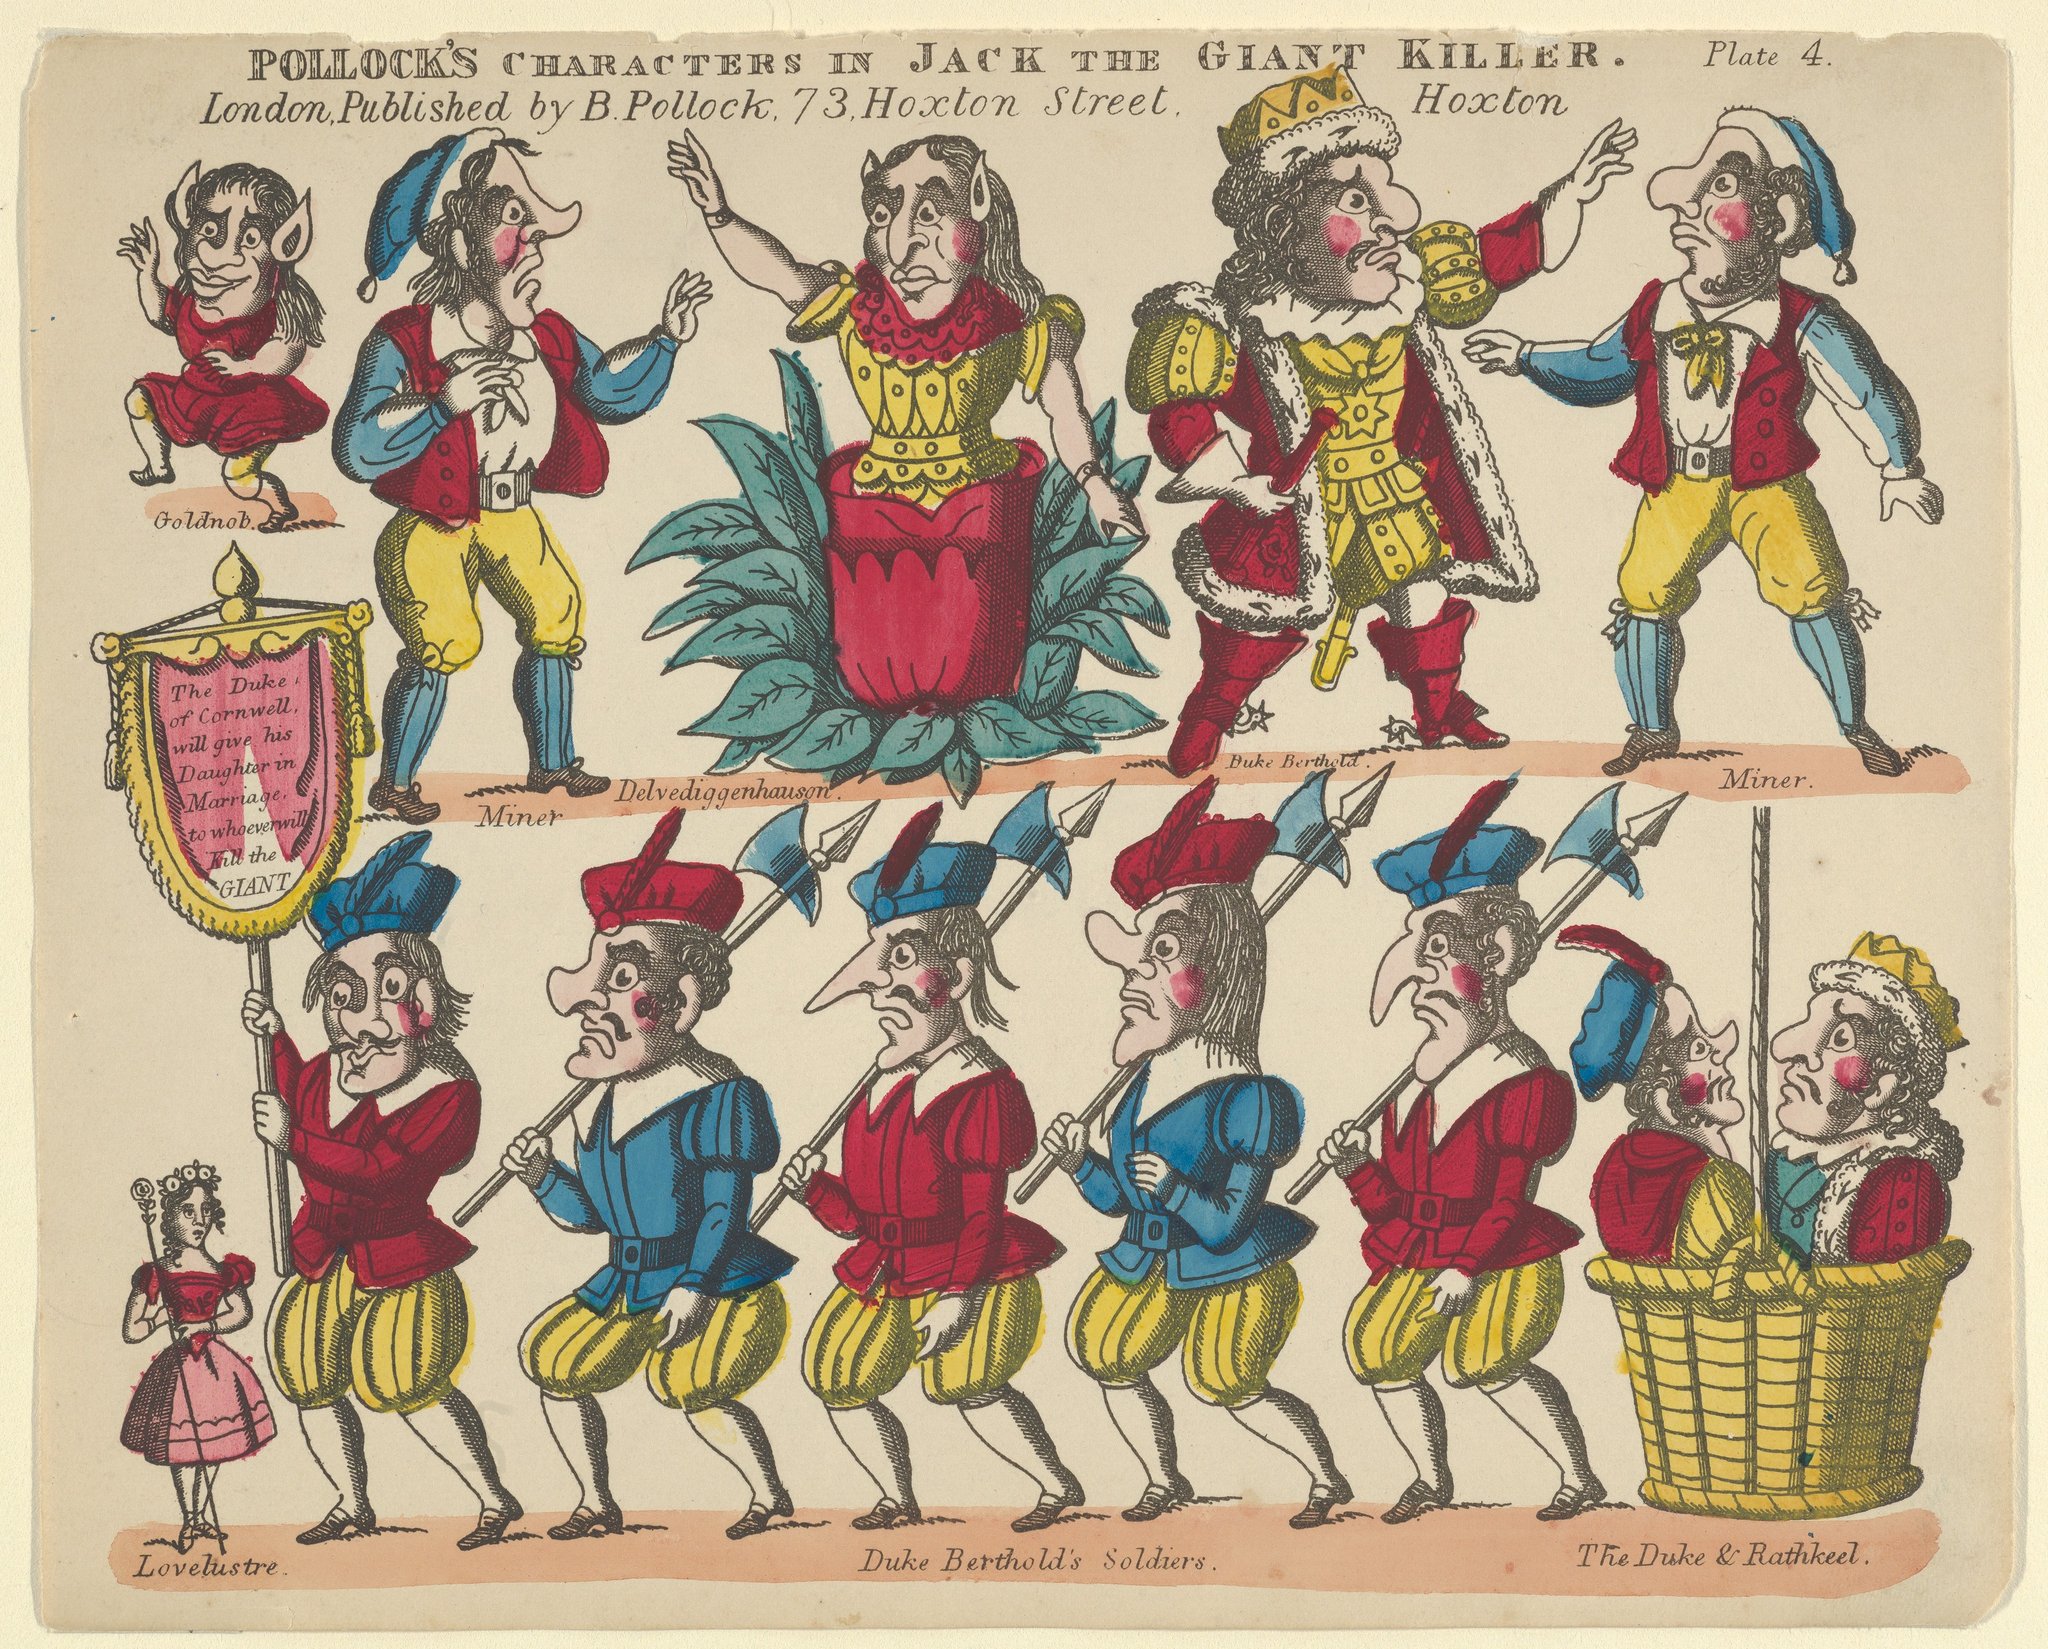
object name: print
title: Characters, from Jack and the Giant Killer, Plate 4 for a Toy Theater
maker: benjamin pollock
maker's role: publisher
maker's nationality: british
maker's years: 1857-1937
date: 1870-1890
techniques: lithograph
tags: soldiers,men,women